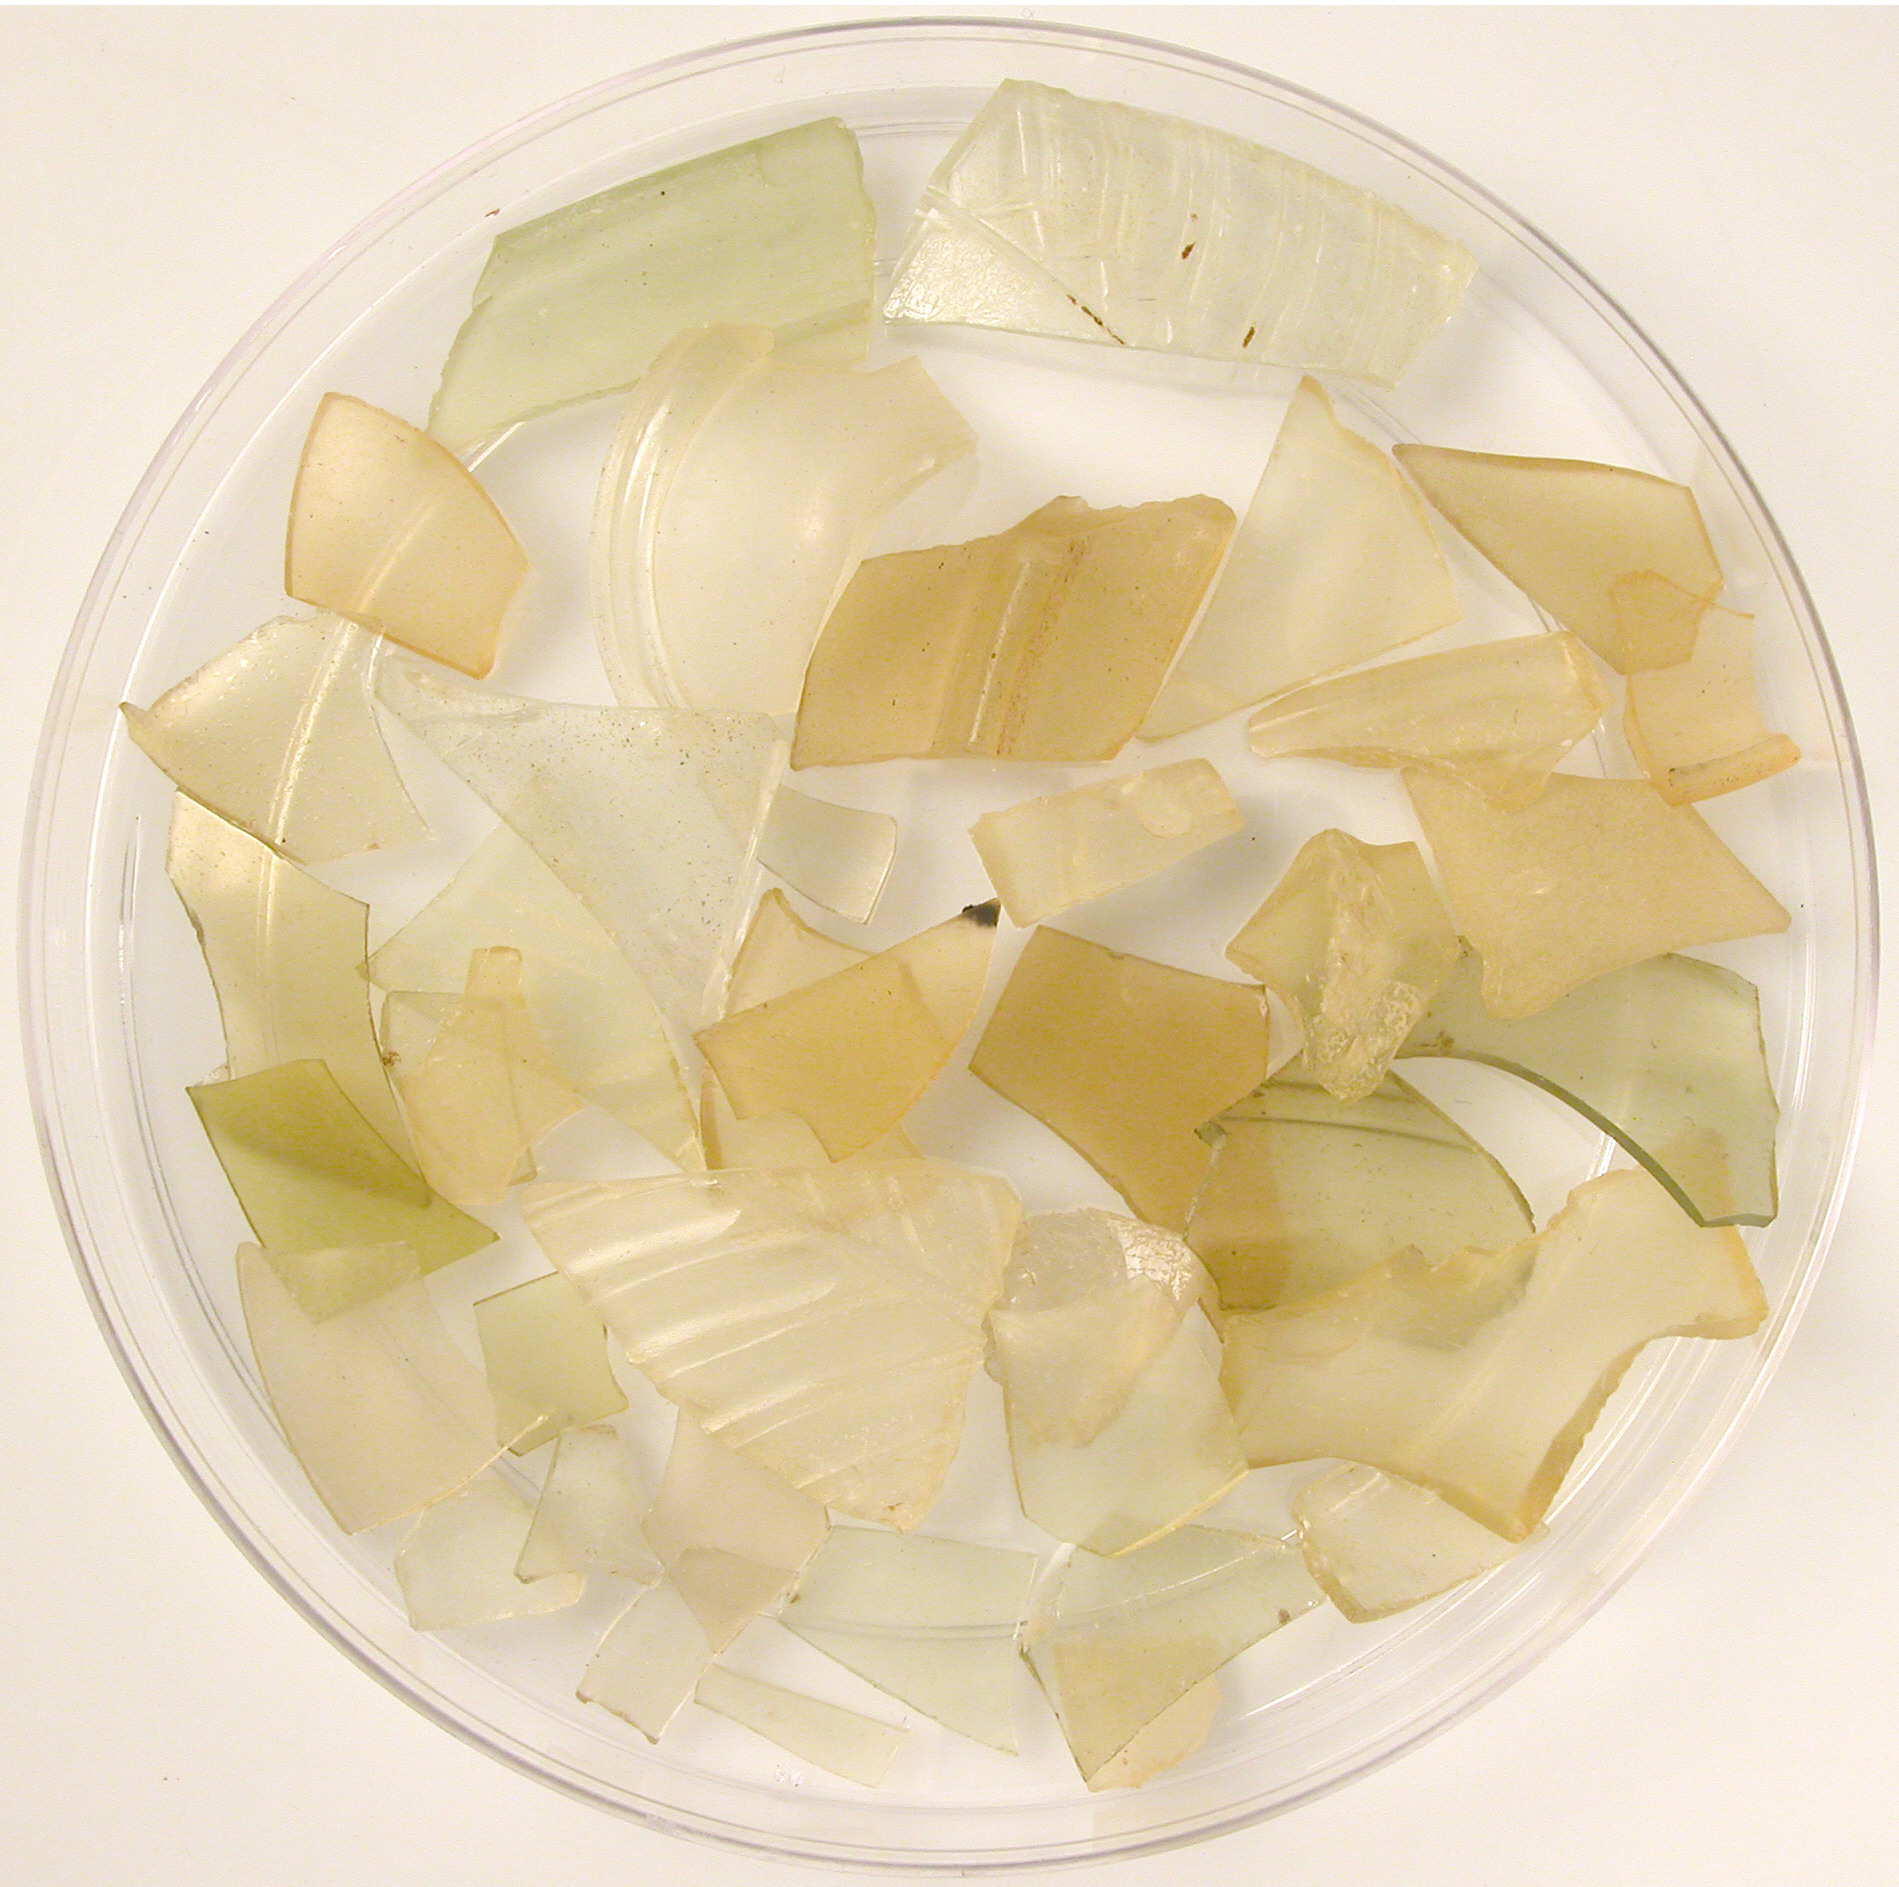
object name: fragment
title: Glass Fragments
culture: coptic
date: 301-700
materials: glass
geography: egypt